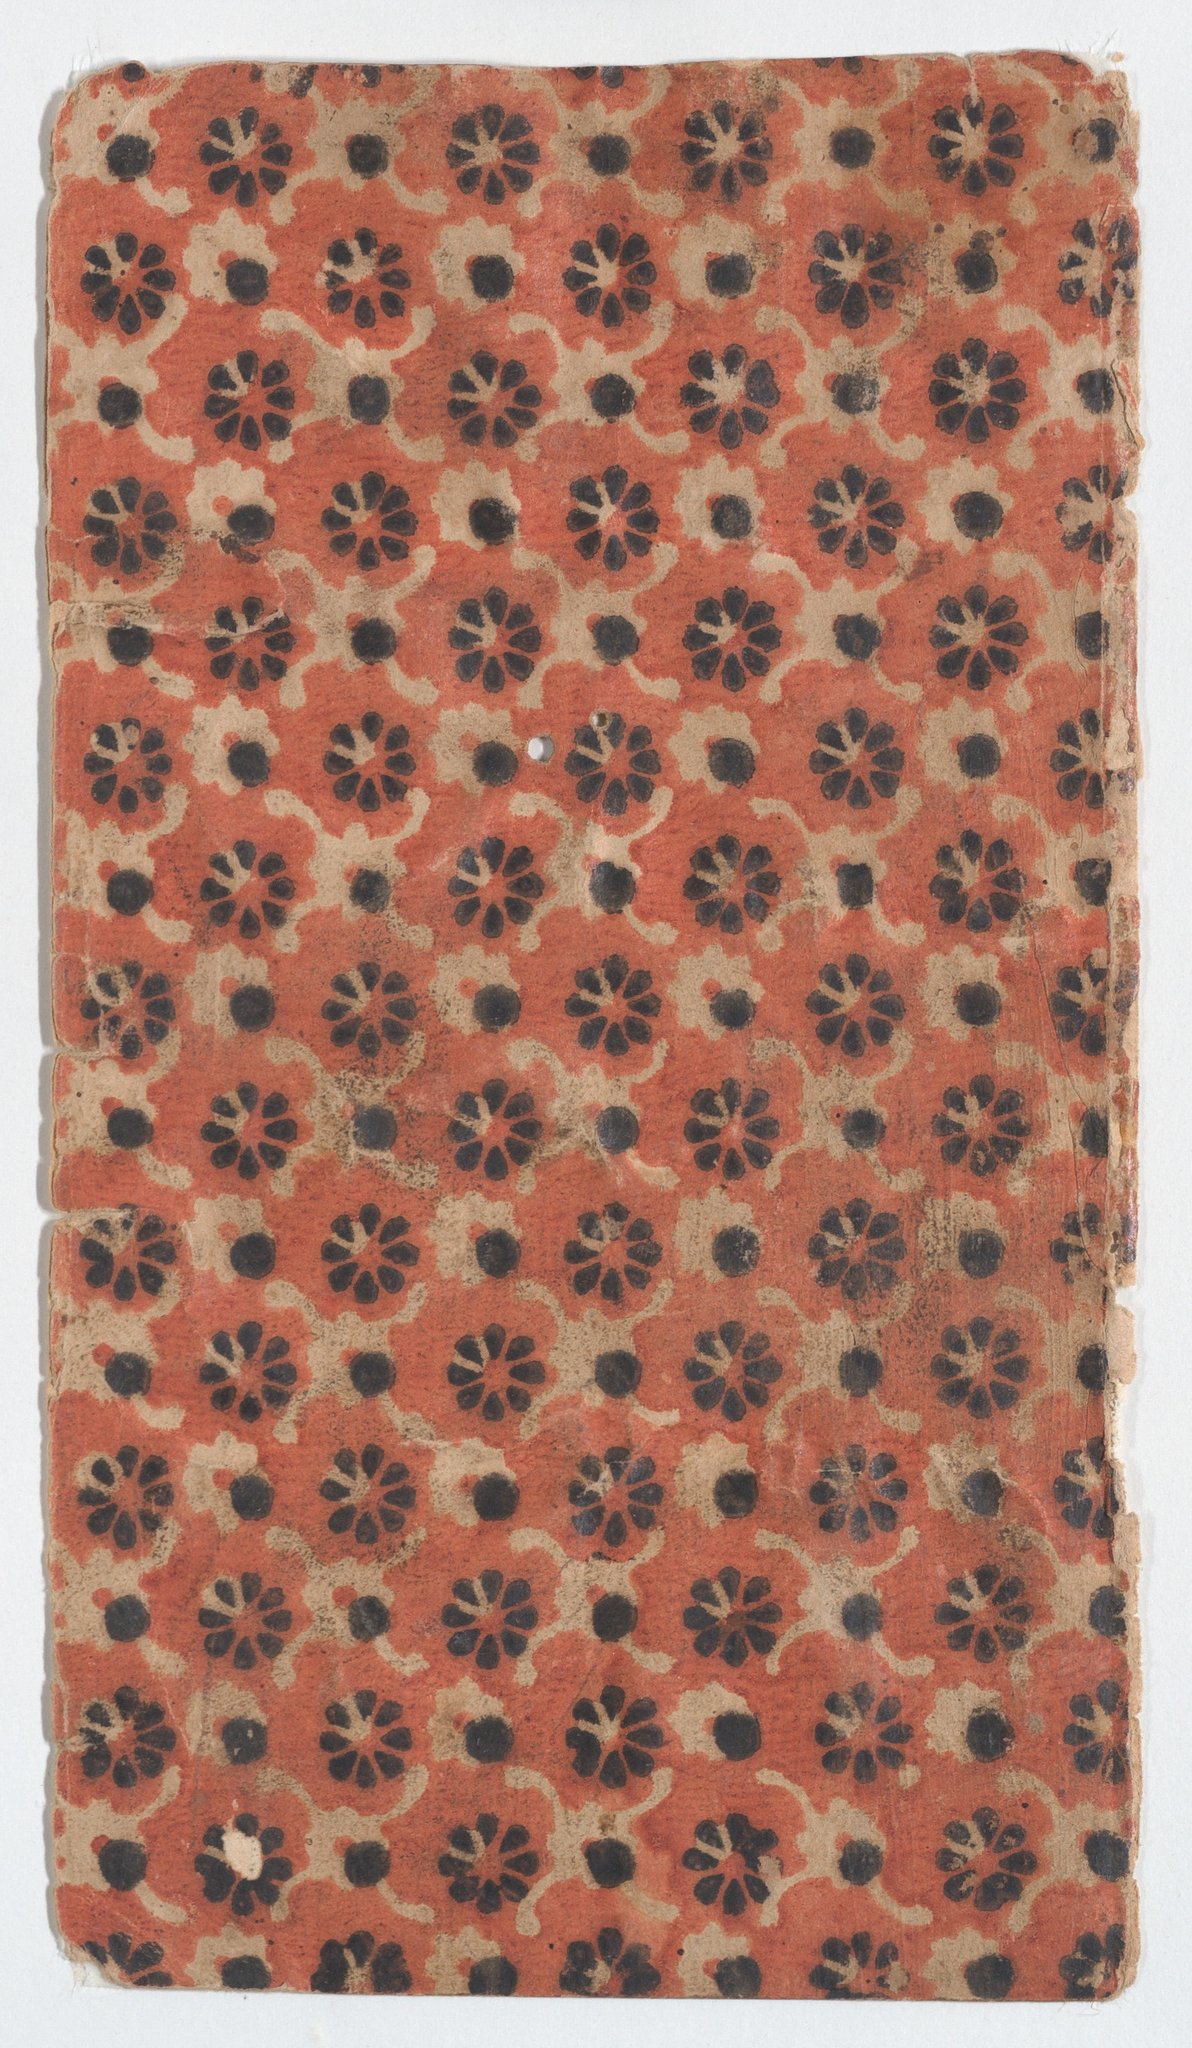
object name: print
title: Sheet with overall floral and dot pattern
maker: Anonymous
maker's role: artist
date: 1801-1900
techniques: relief print